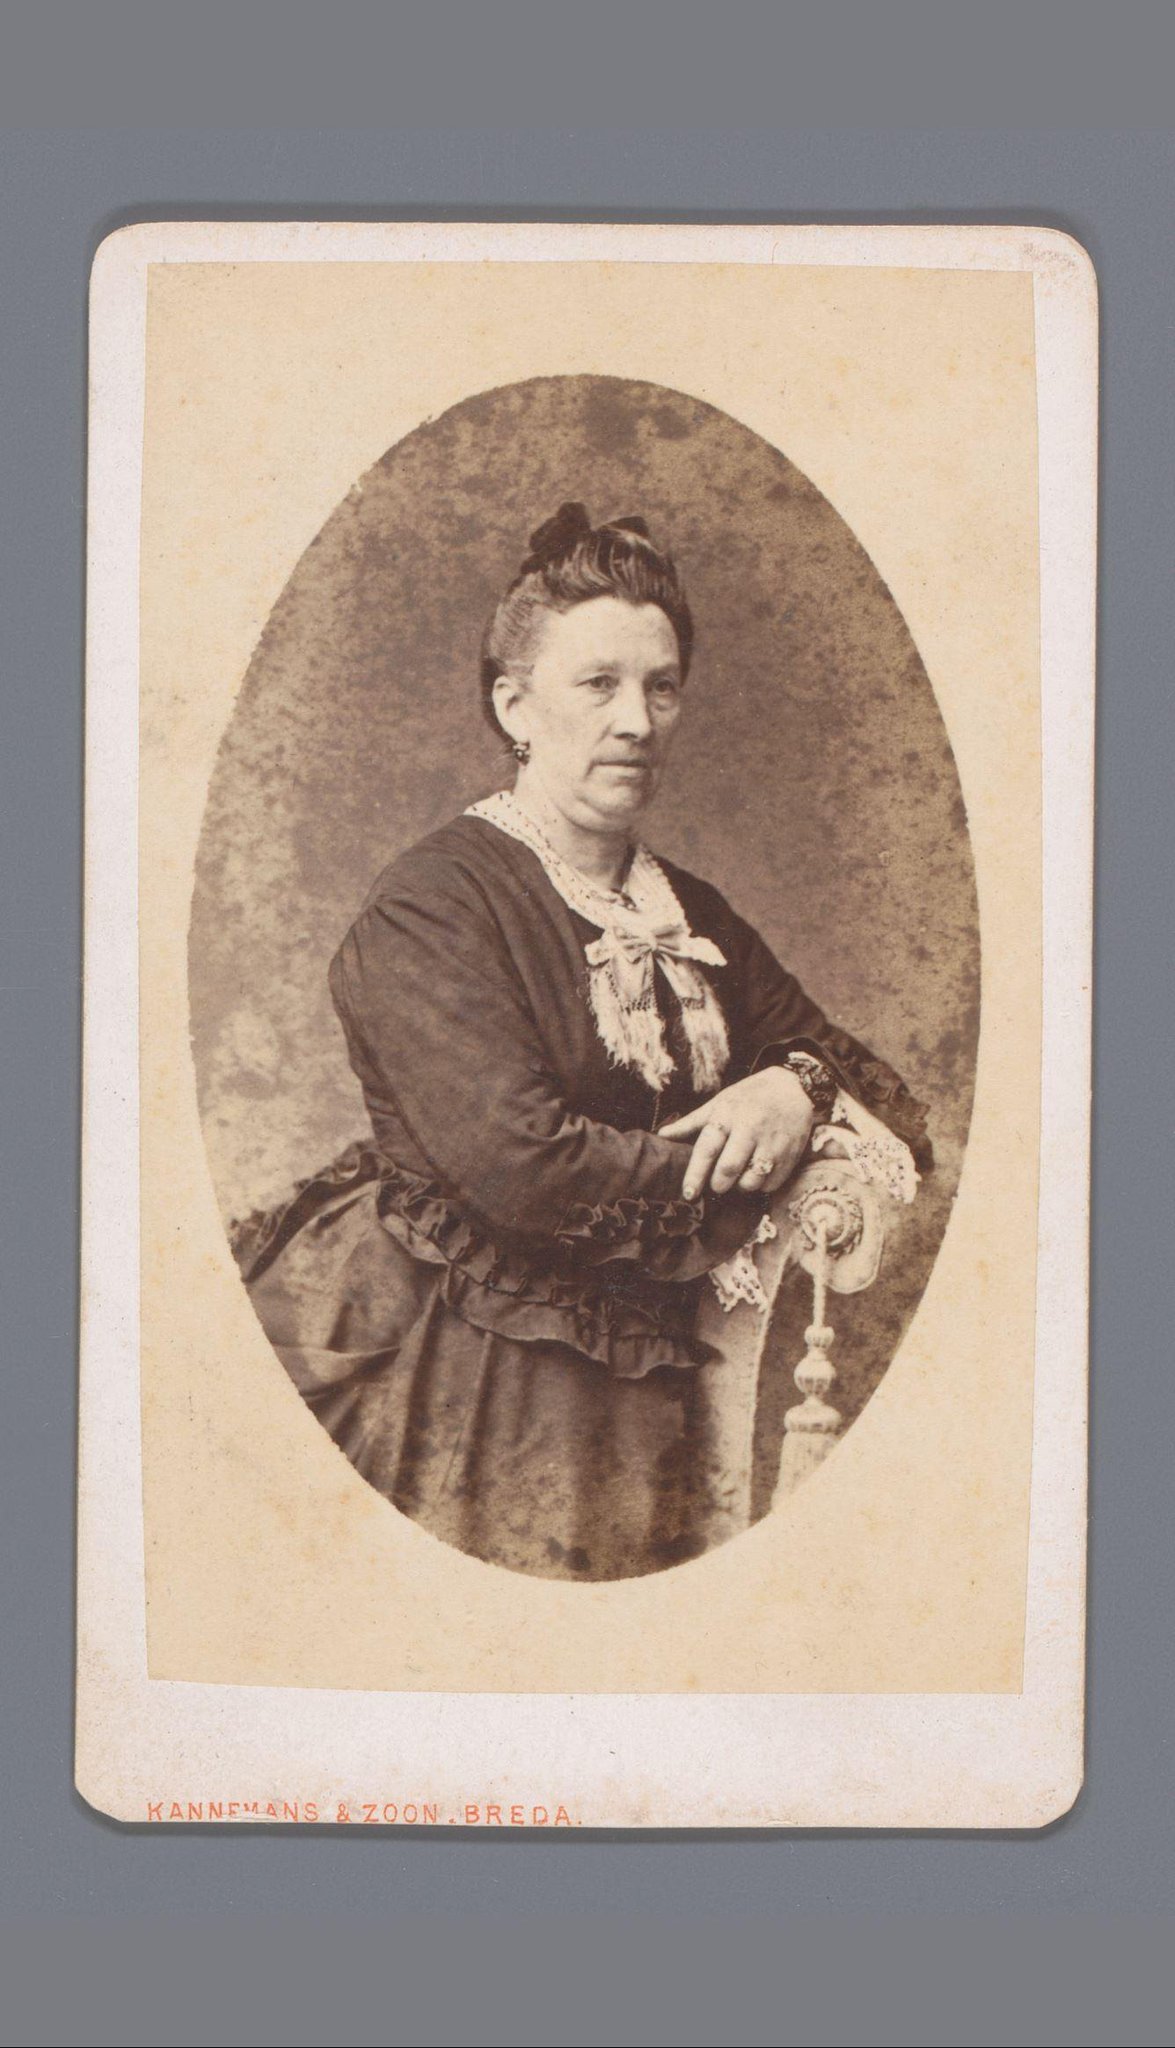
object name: photograph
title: Portret van een onbekende vrouw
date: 1867-1879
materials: cardboard, paper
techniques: albumen print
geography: breda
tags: historical persons - bb - woman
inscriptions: inscription: ‘KANNEMANS EN ZOON/ Artiste Photographen/ VAN/ Z.M. DEN KONING en H.M. de KONINGIN/ BREDA/ Groote Markt/ D. 15/ tegen over het Stadhuis’